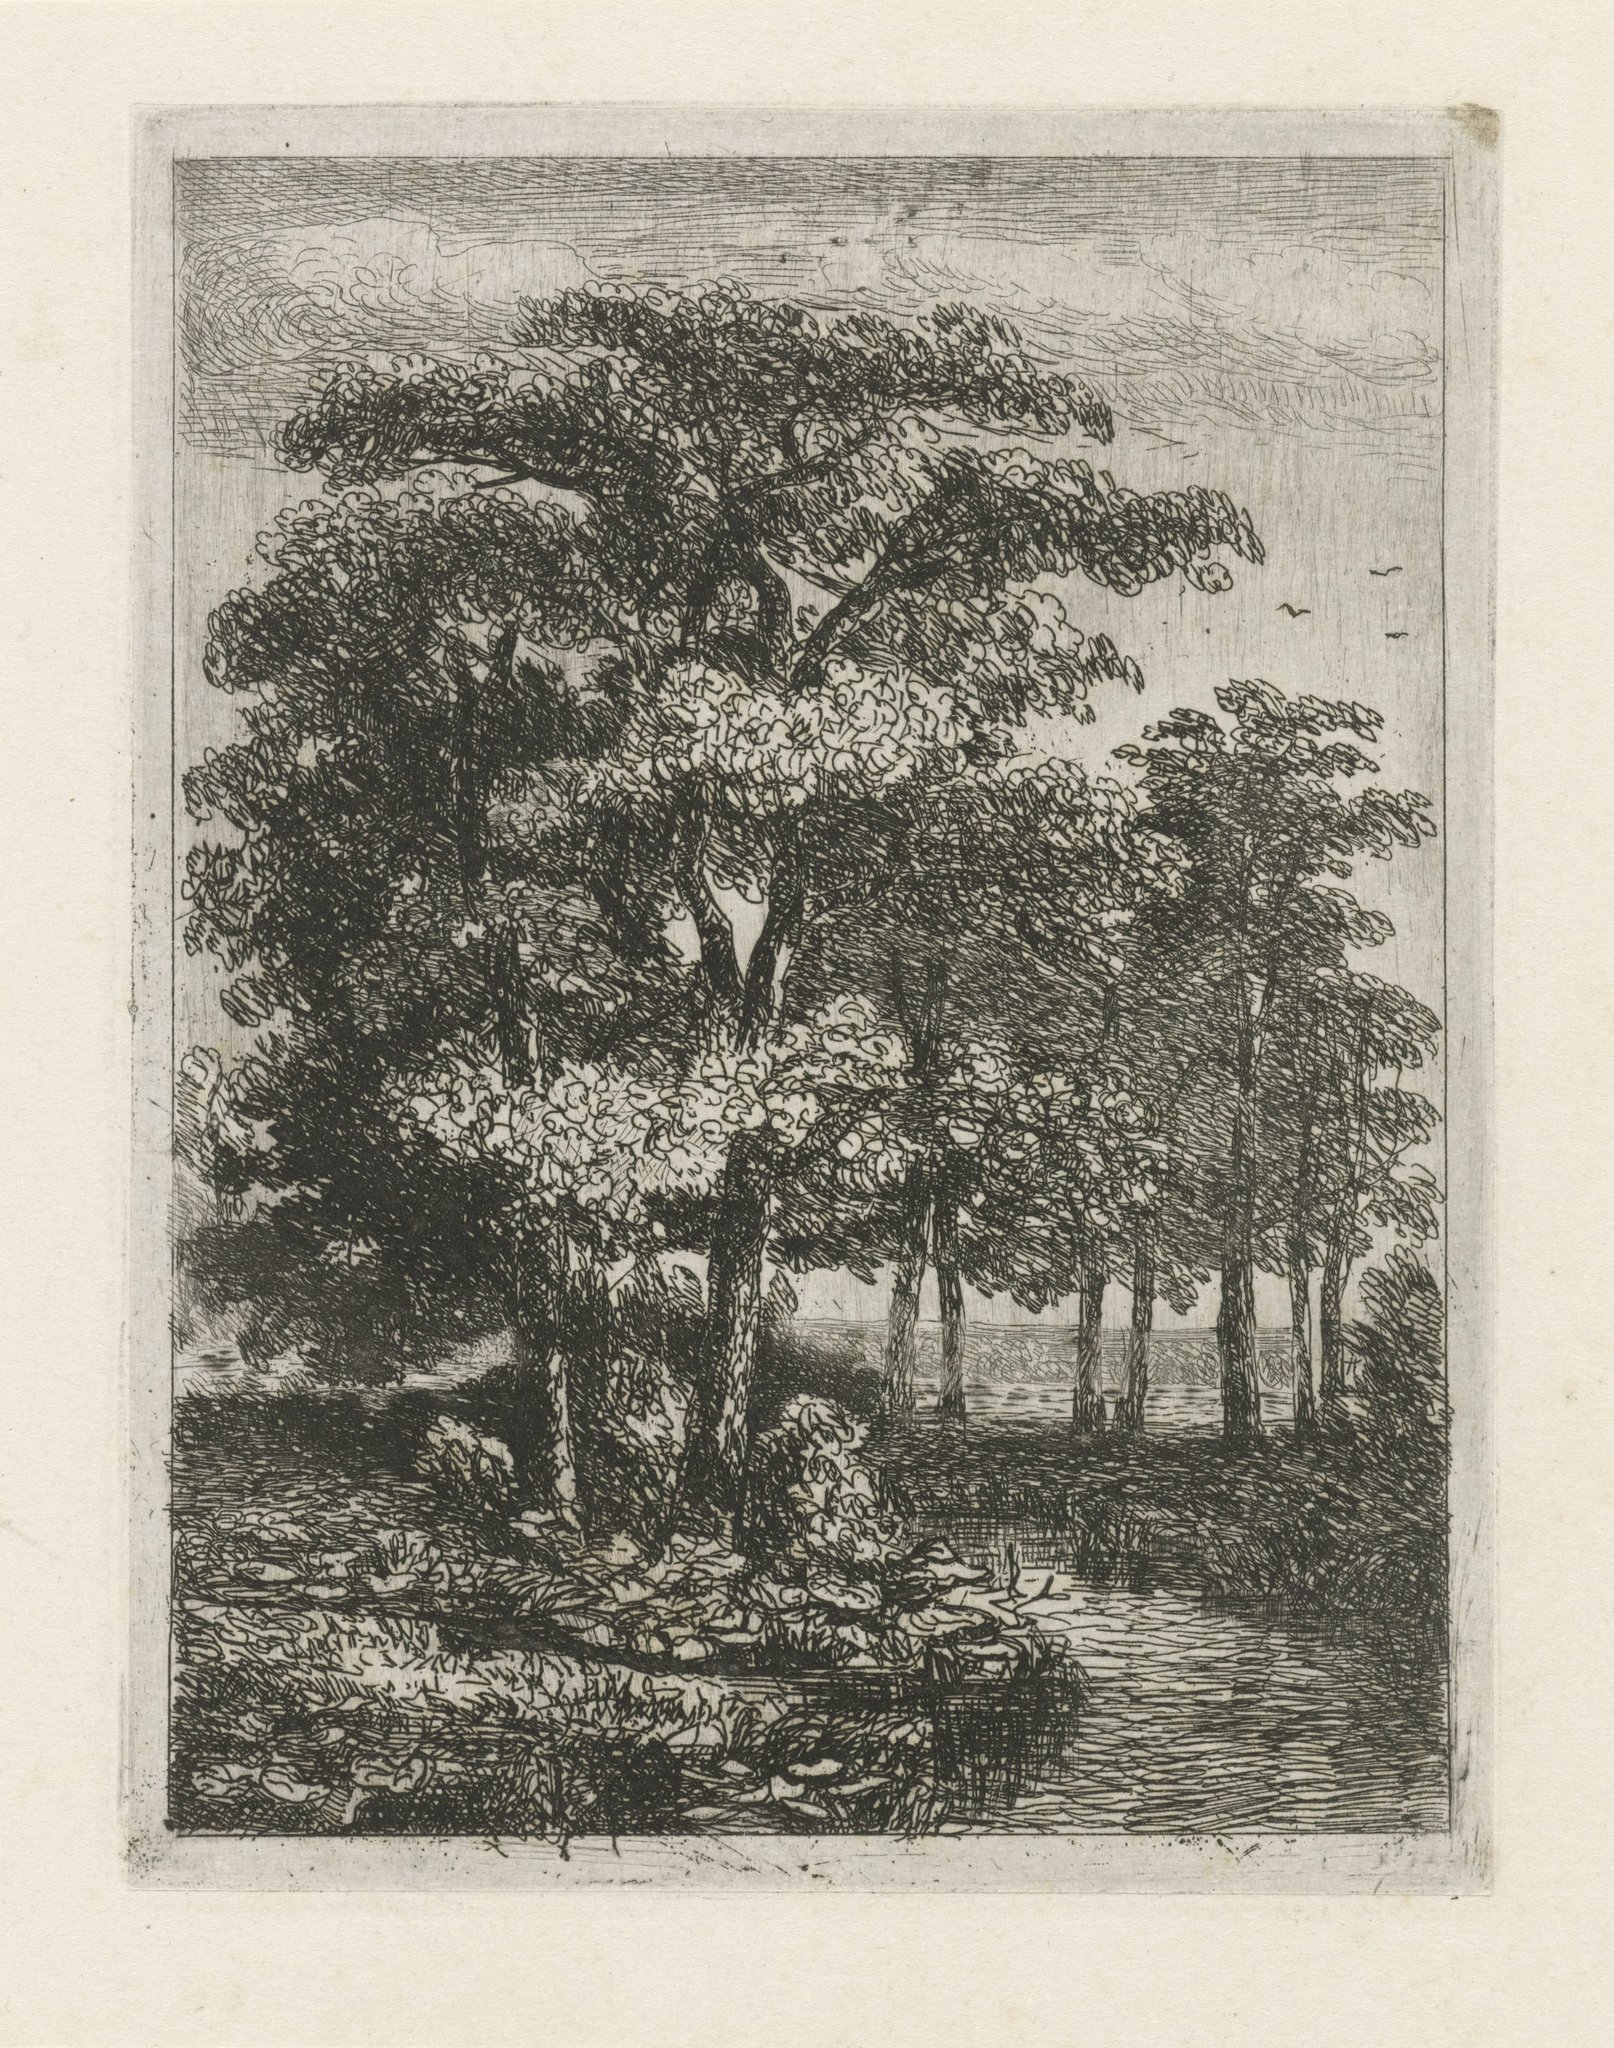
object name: print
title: Geboomte bij een beek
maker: hermanus jan hendrik van rijkelijkhuysen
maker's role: painter, print maker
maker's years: 1813-1883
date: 1823-1883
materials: paper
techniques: drypoint, etching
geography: utrecht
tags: brook, groups of trees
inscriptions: collector's mark: Lugt 2228, collector's mark: Lugt 1485